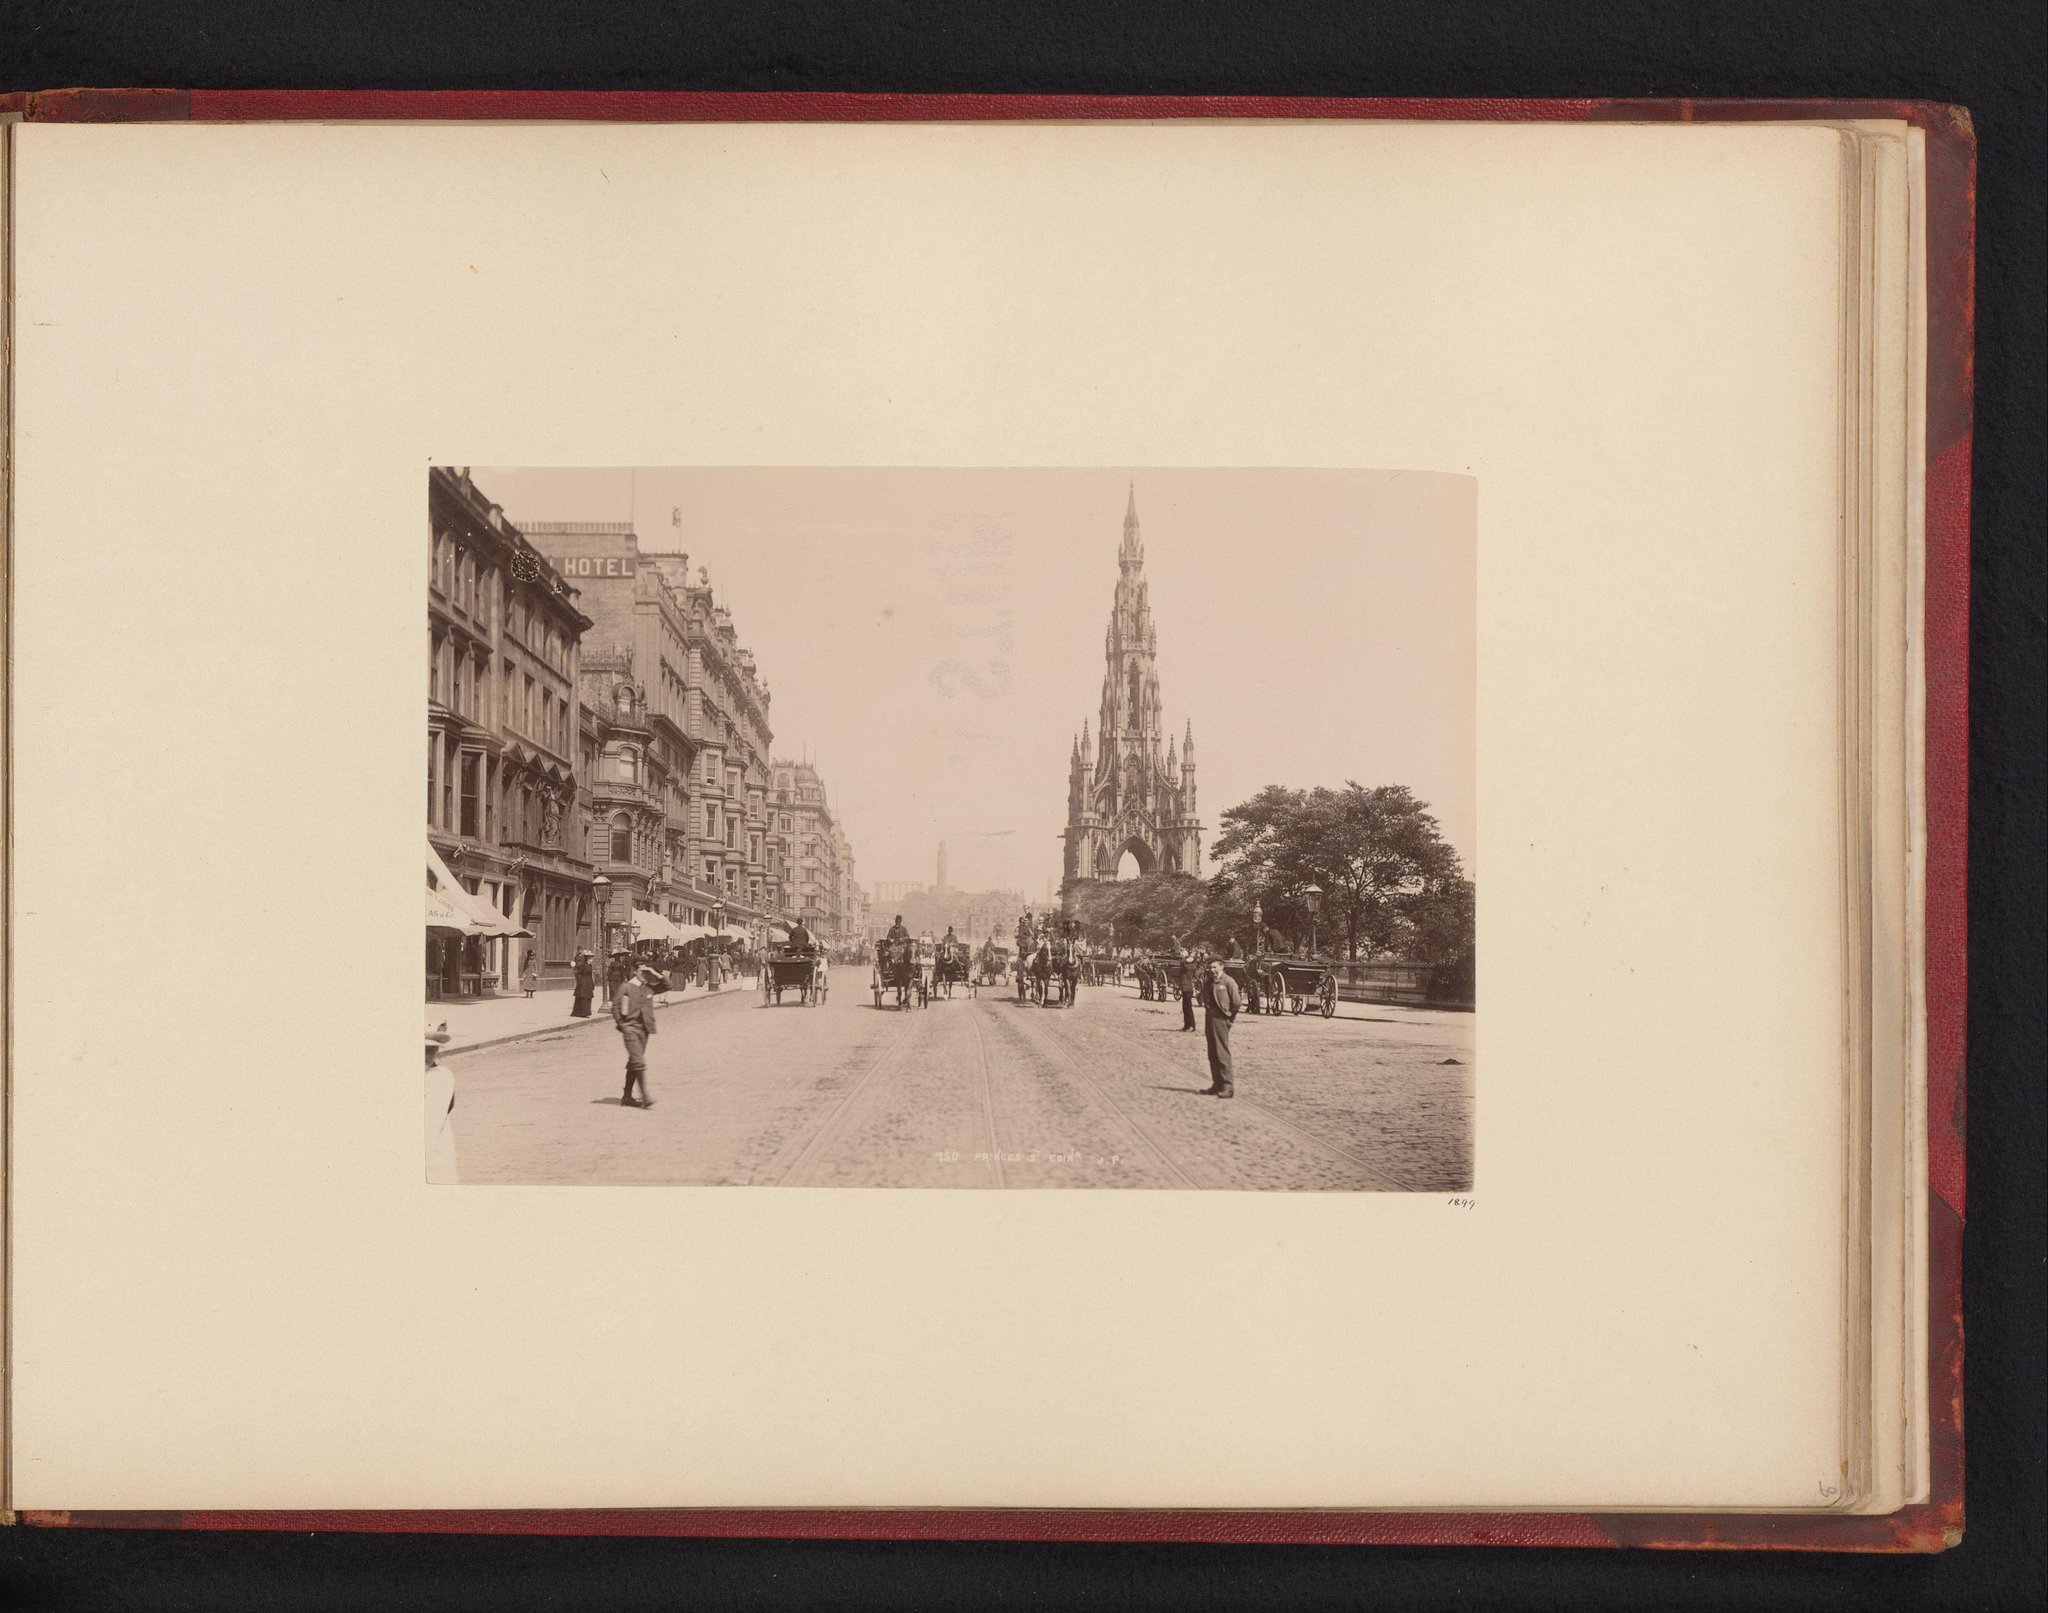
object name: album leaf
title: Gezicht op Princess Street met het Scott Monument te Edinburgh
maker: james patrick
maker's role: fotograaf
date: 1899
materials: photographic support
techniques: albumen print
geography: edinburgh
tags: monument, statue (+ city(-scape) with figures, staffage), street (+ city(-scape) with figures, staffage)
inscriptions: annotation: ‘1899’, inscription: ‘[150.] Princes st. Edinr J.P.’